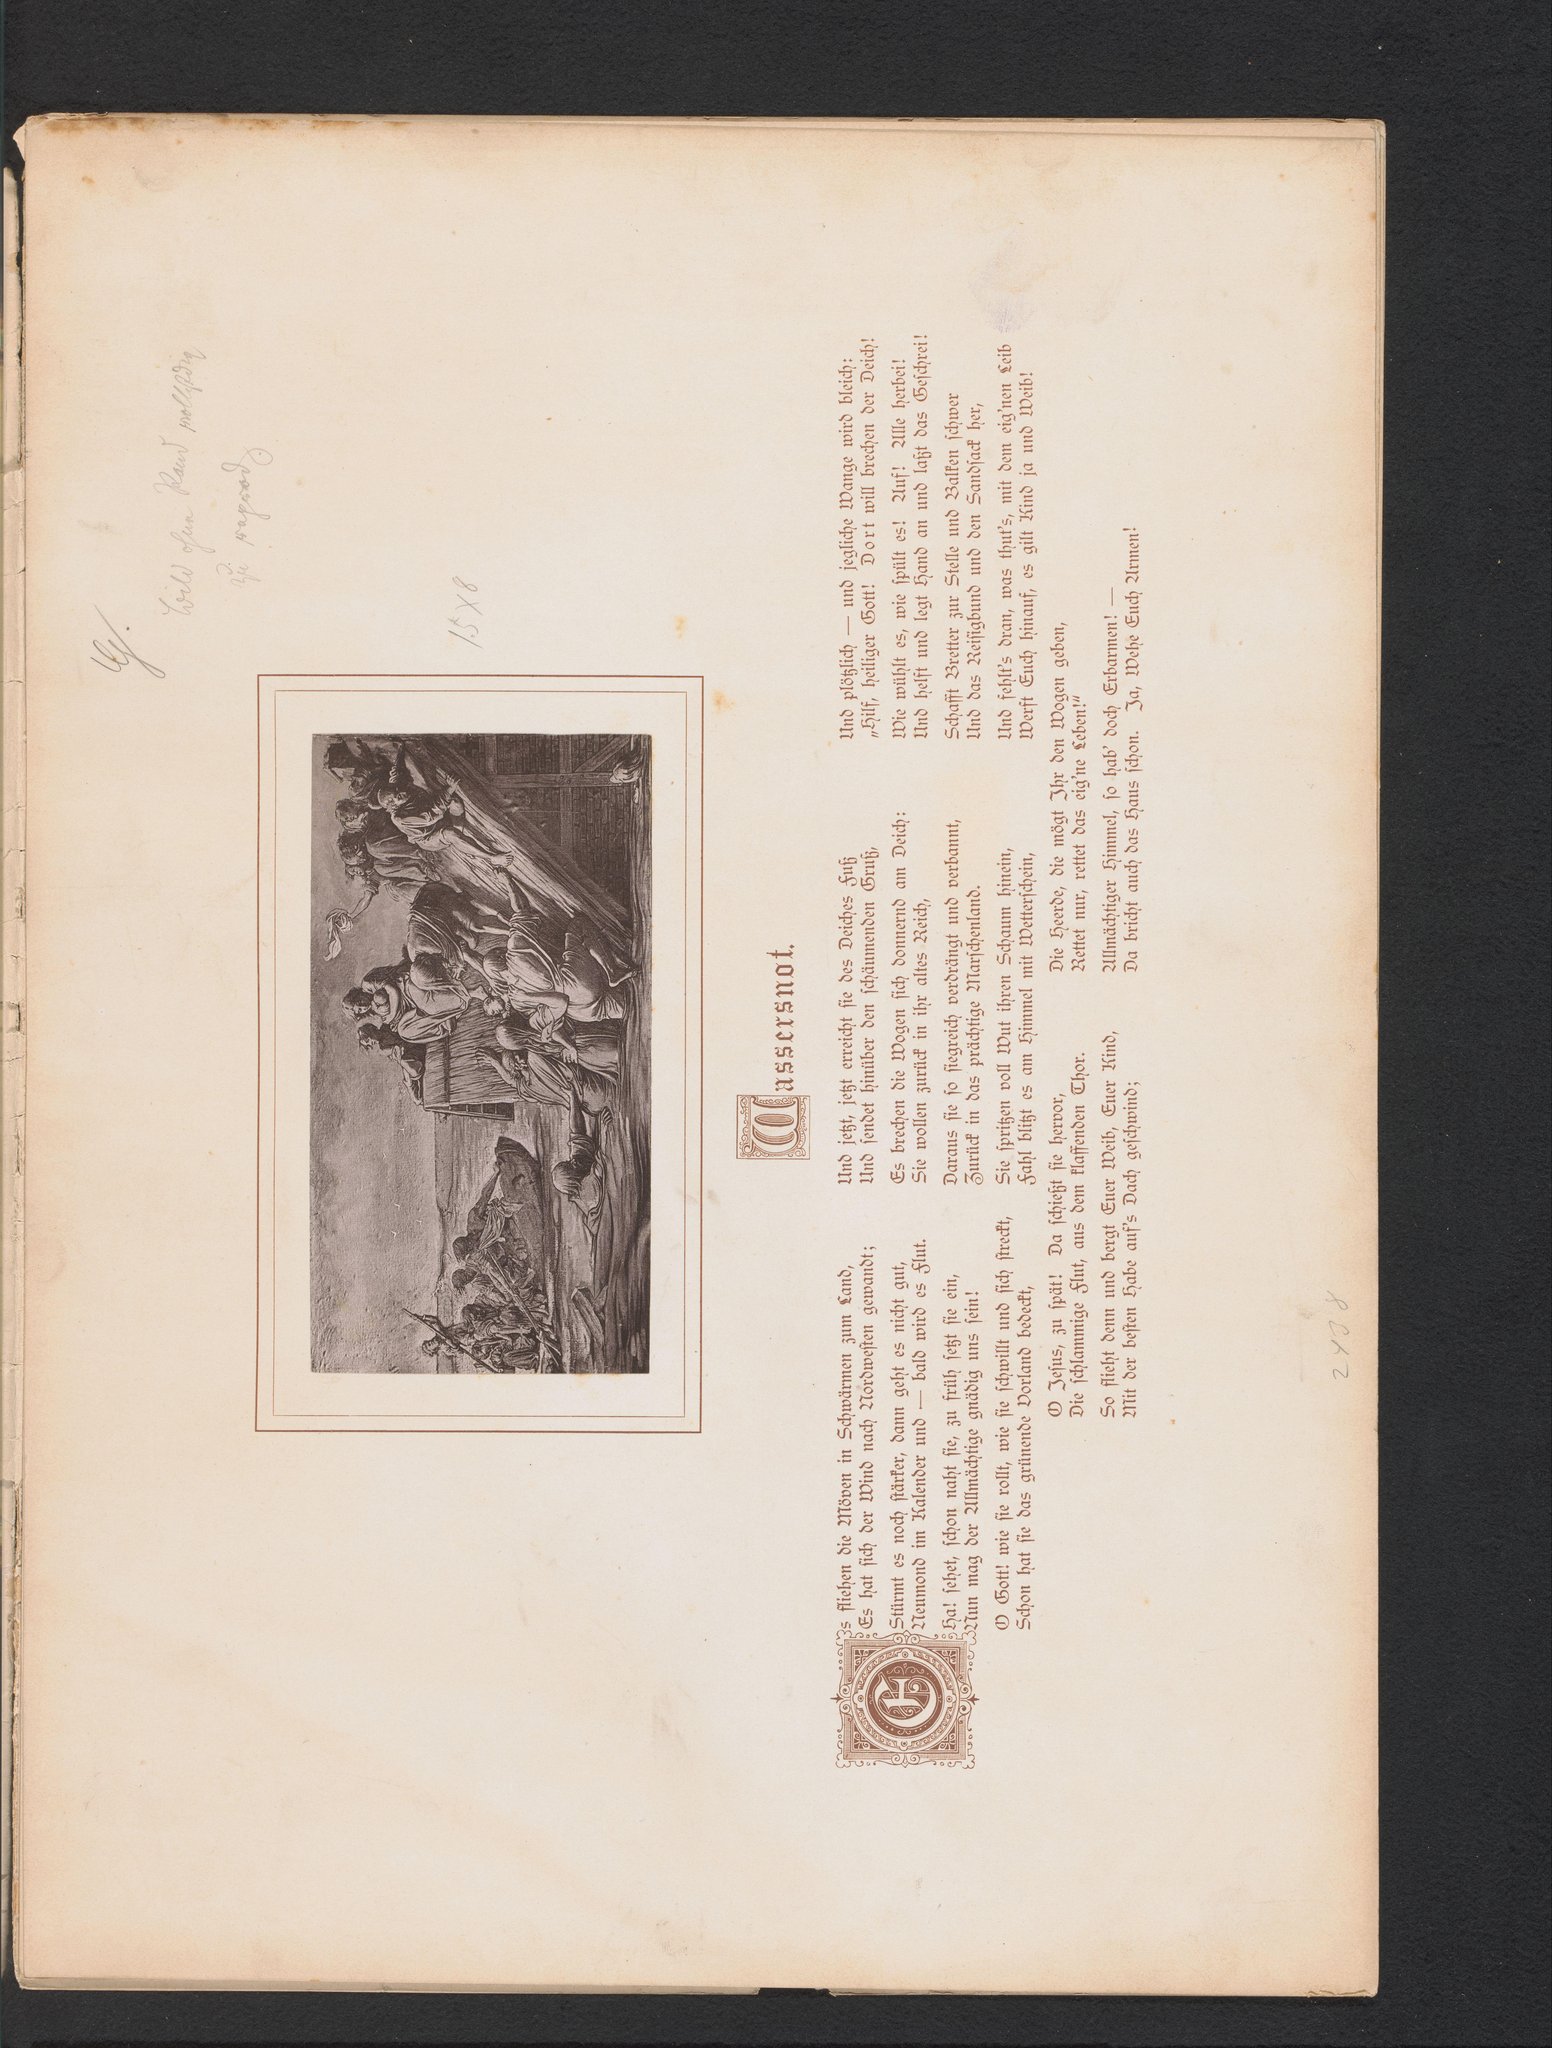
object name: photomechanical print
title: Reproductie van een schilderij van watersnood door Heinrich von Dörnberg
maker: Anonymous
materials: paper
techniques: photograph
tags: flood (+ landscape with figures, staffage)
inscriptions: number: ‘2438’, annotation: ‘G./ bild of[..] Rand [.]ollessdig/ zu [...]/’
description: Deze prent maakt deel uit van een omslag met zes prenten en een tekstblad.